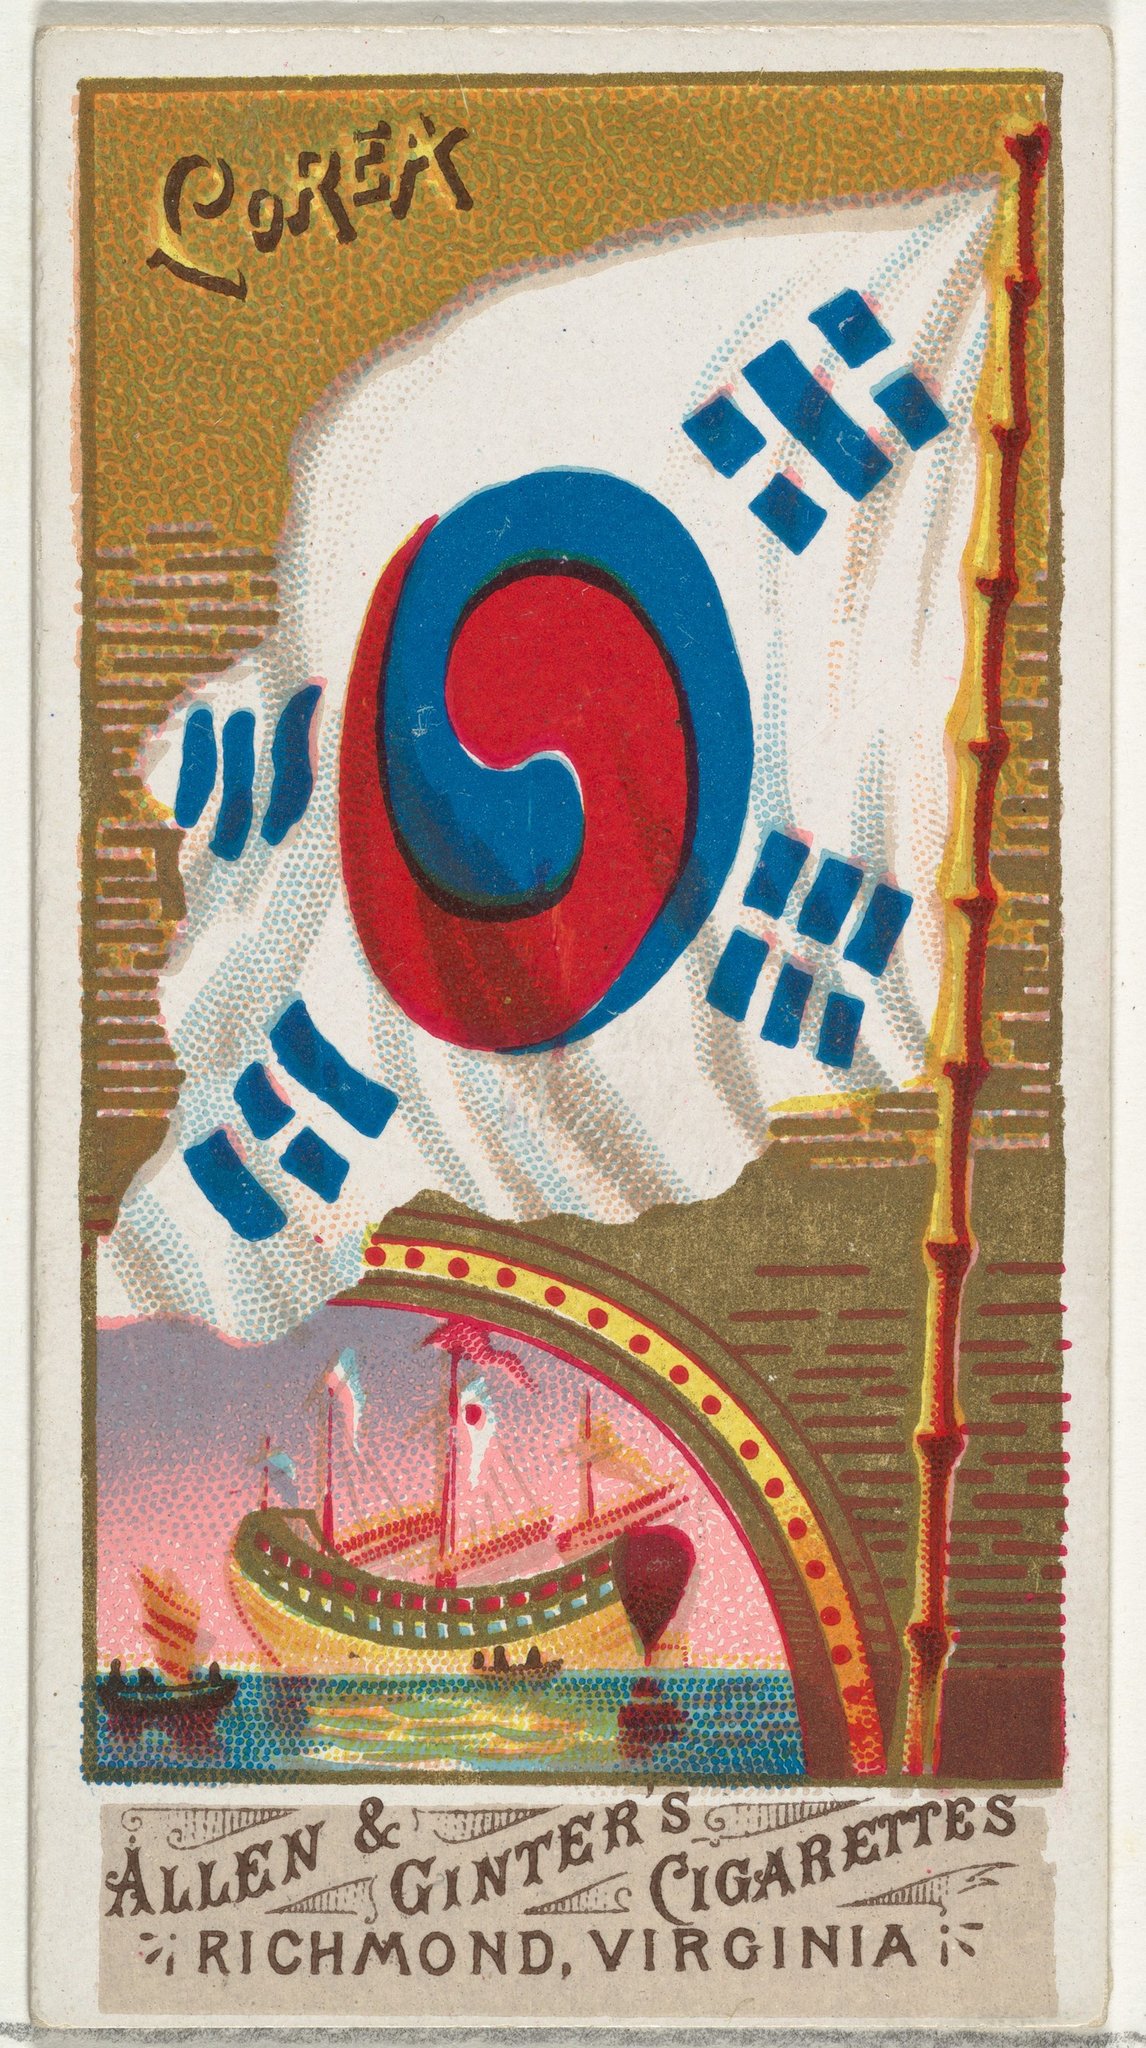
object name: print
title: Korea, from Flags of All Nations, Series 1 (N9) for Allen & Ginter Cigarettes Brands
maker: allen & ginter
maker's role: publisher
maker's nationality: american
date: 1887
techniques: color lithograph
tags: flags